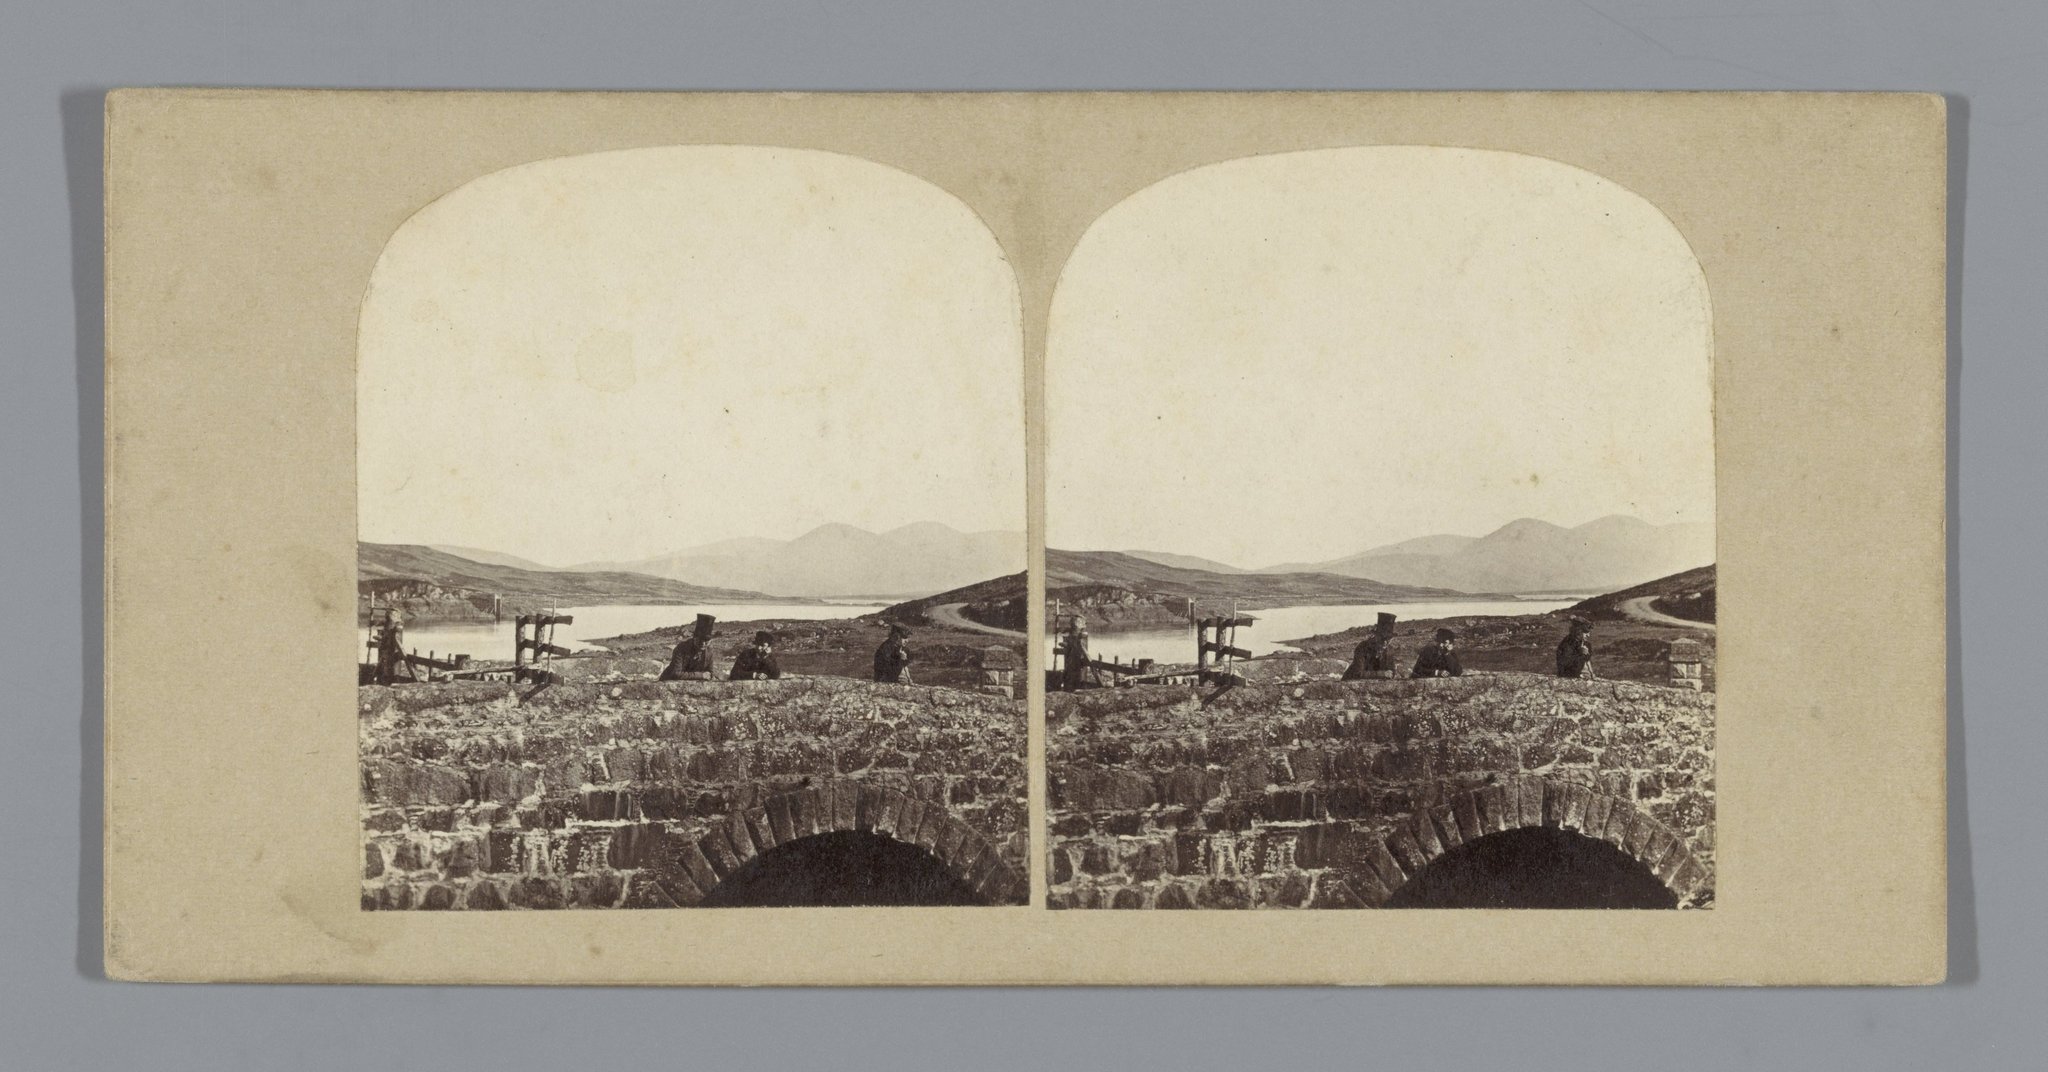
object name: stereograph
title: Scotland. Loch Doon, Ayreshire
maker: Anonymous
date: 1850-1880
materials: cardboard, photographic support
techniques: albumen print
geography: ayrshire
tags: lake, bridge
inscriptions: number: ‘No. 76.’, number: ‘34’, name: ‘Kunsthandlung Joh. Heinrigs in Cöln Hochstrasse 152. (...)’